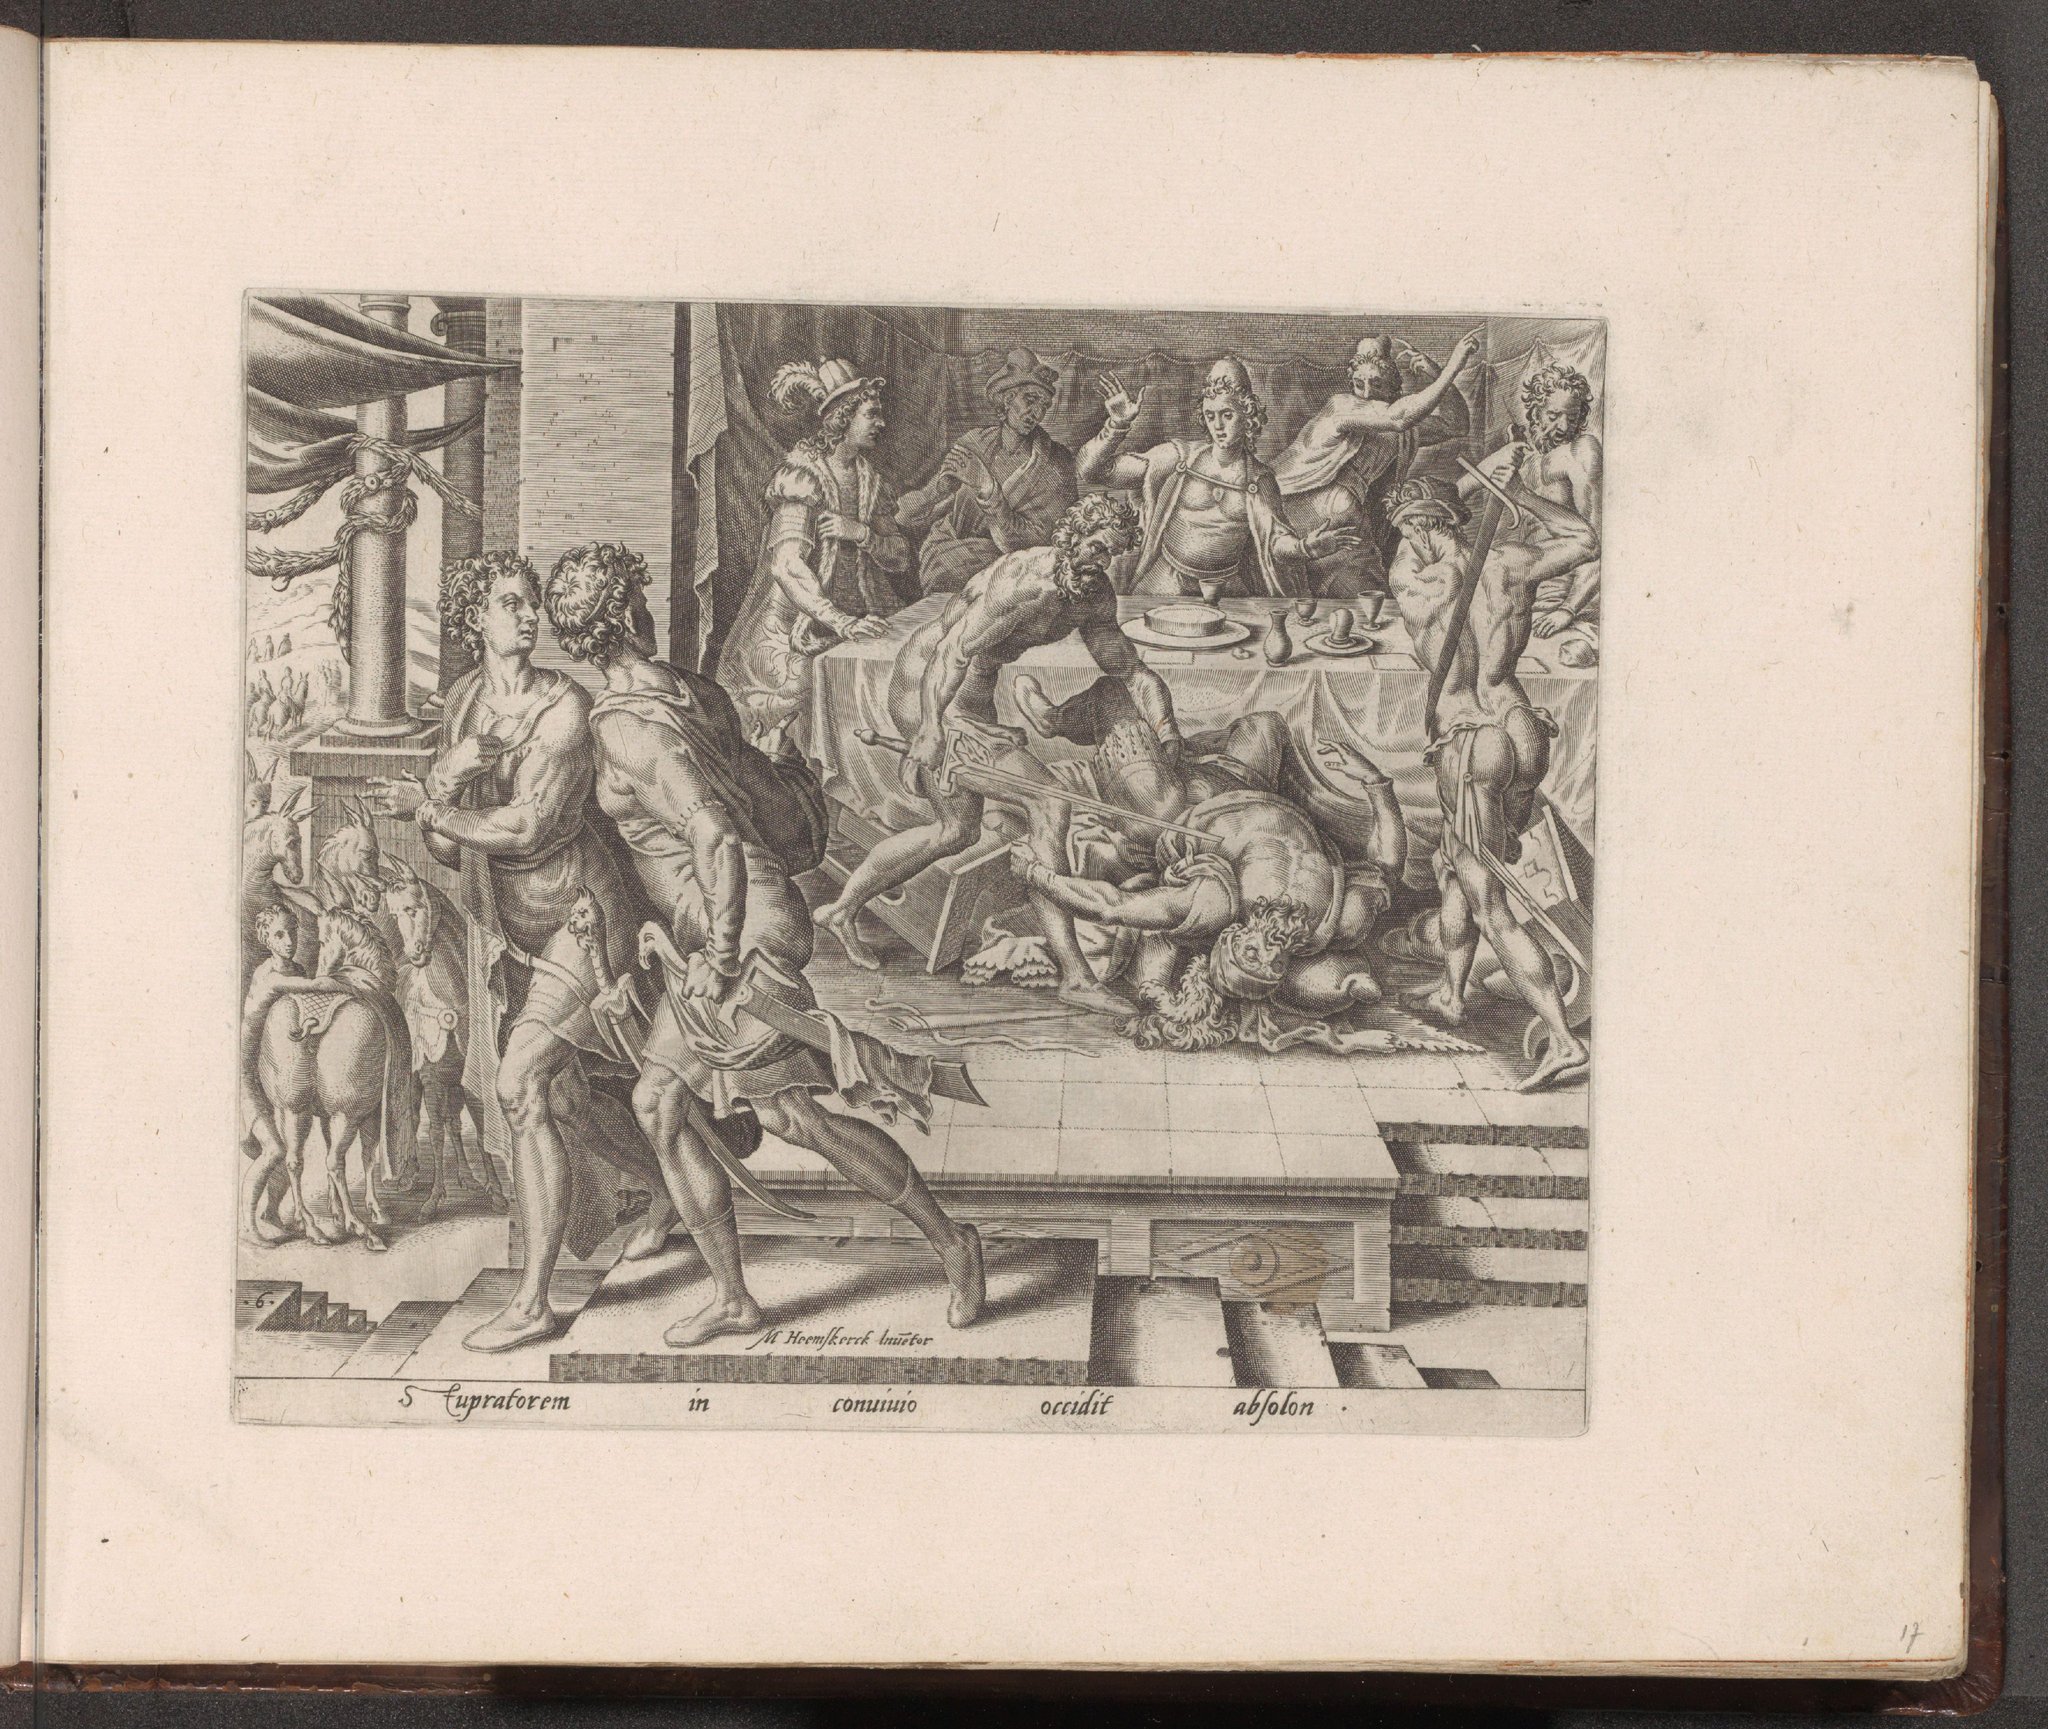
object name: print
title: Thesaurus sacrarum historiaru[m] veteris testame[n]ti, elega[n]tissimis imaginibus expressu[m] excelle[n]tissimoru[m] in hac arte viroru[m] opera: nu[n]c primu[m] in luce[m] editus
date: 1559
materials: paper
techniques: engraving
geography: haarlem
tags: amnon is murdered at absalom's banquet, the princes flee from absalom's banquet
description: Bij een diner voor de koningszonen laat Absalom zijn halfbroer Amnon vermoorden door zijn dienaren. Twee mannen vallen Amnon met zwaarden aan en vermoorden hem. De andere koningszonen vluchten en vertrekken links op hun muildieren. Onder de voorstelling een verwijzing in het Latijn naar de Bijbeltekst. Prent maakt deel uit van een album.